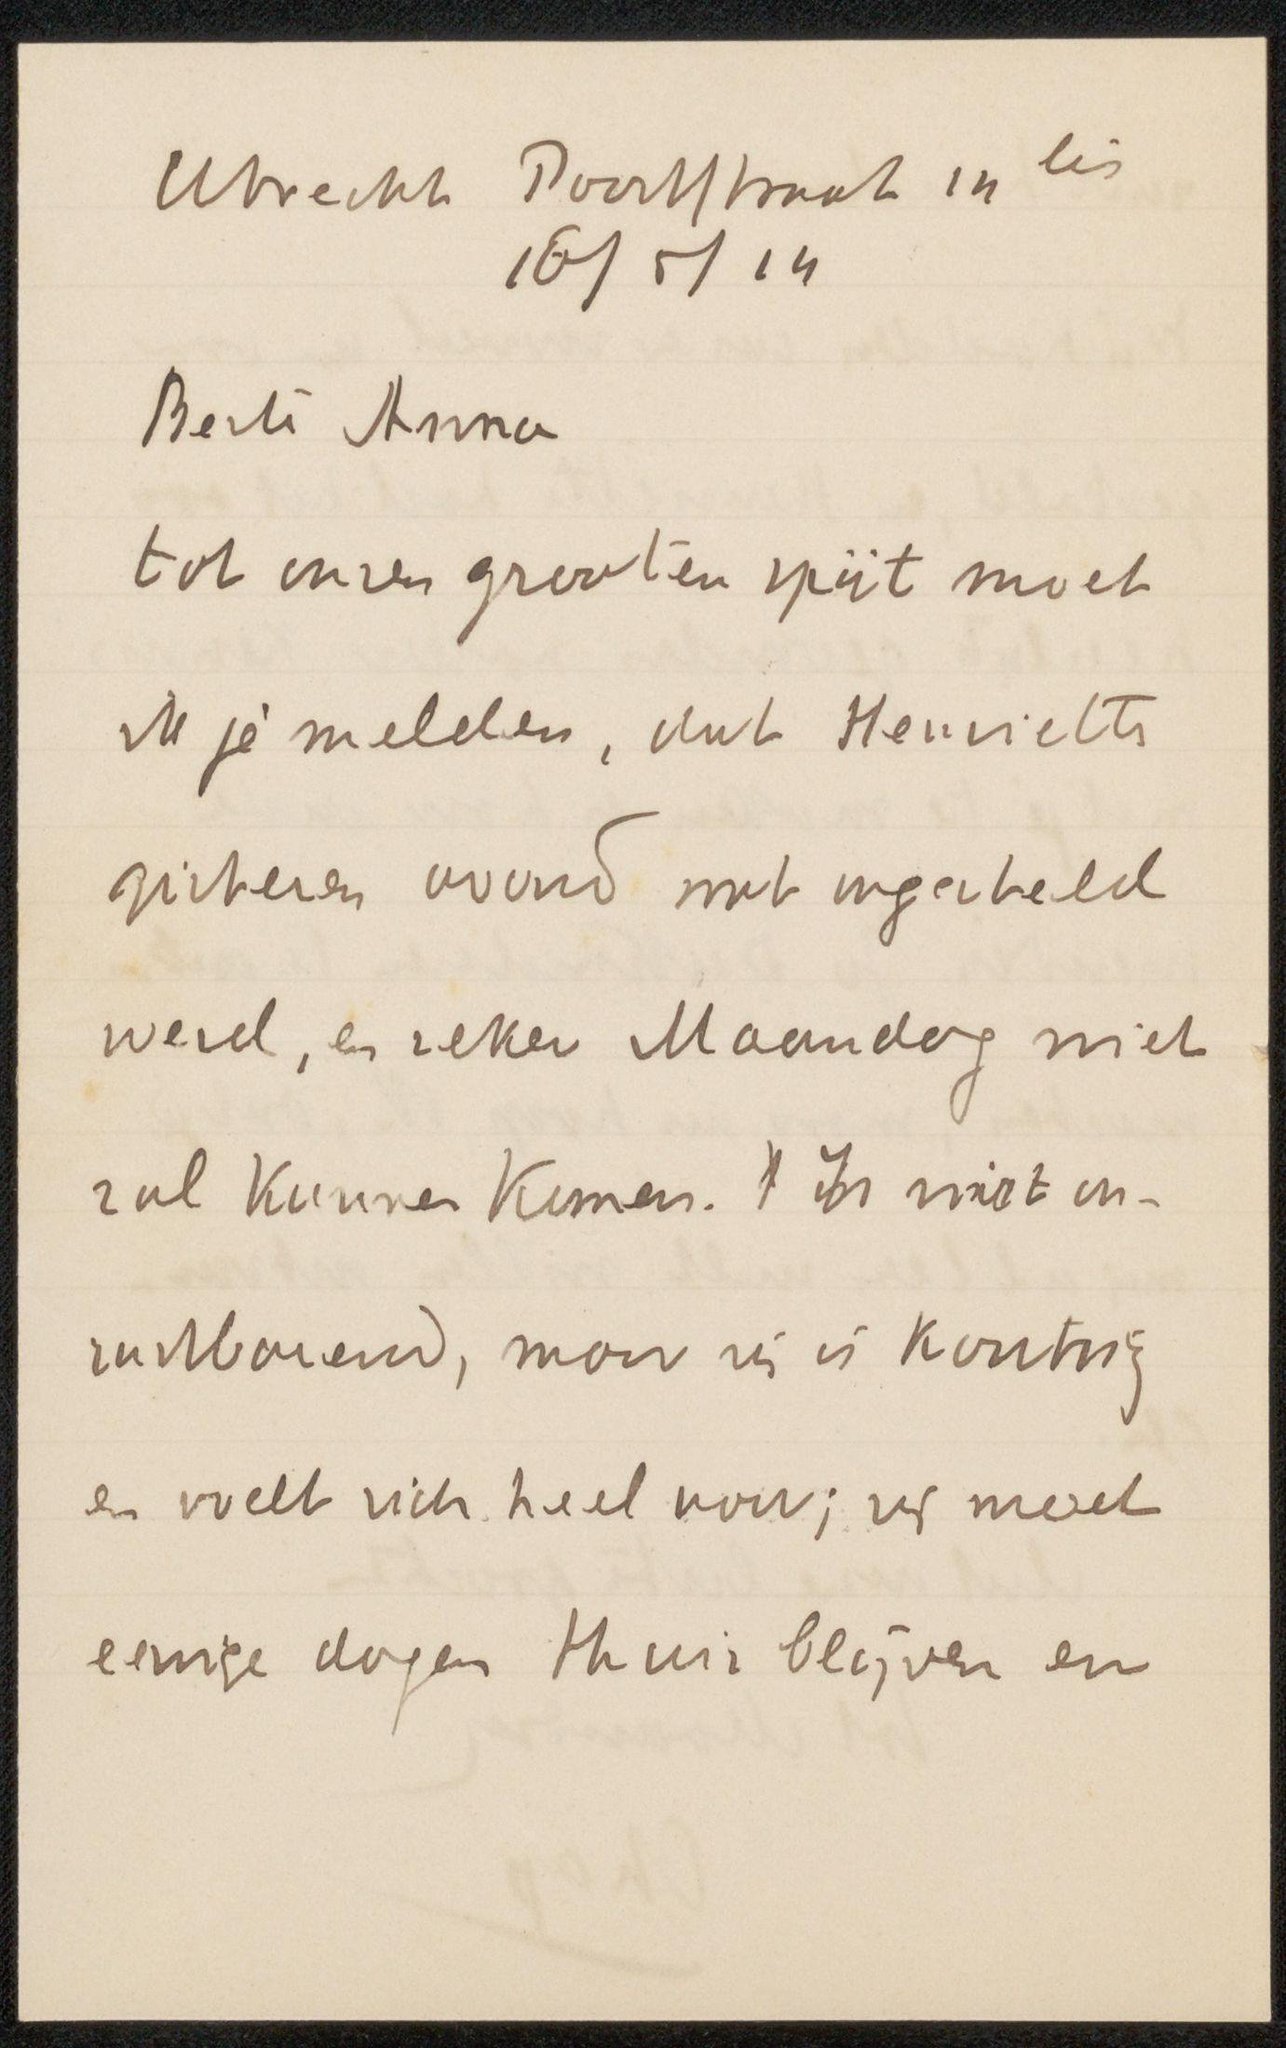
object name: letter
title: Brief aan Anna Dorothea Dirks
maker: chap van deventer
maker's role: kunstcriticus, scheikundige, schrijver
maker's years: 1860-1931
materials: ink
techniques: pen, writing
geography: utrecht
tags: print maker, johanna henriëtte besier, artist, anna dorothea dirks, catharina henriette perk, diseases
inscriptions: collector's mark: ‘RPK’